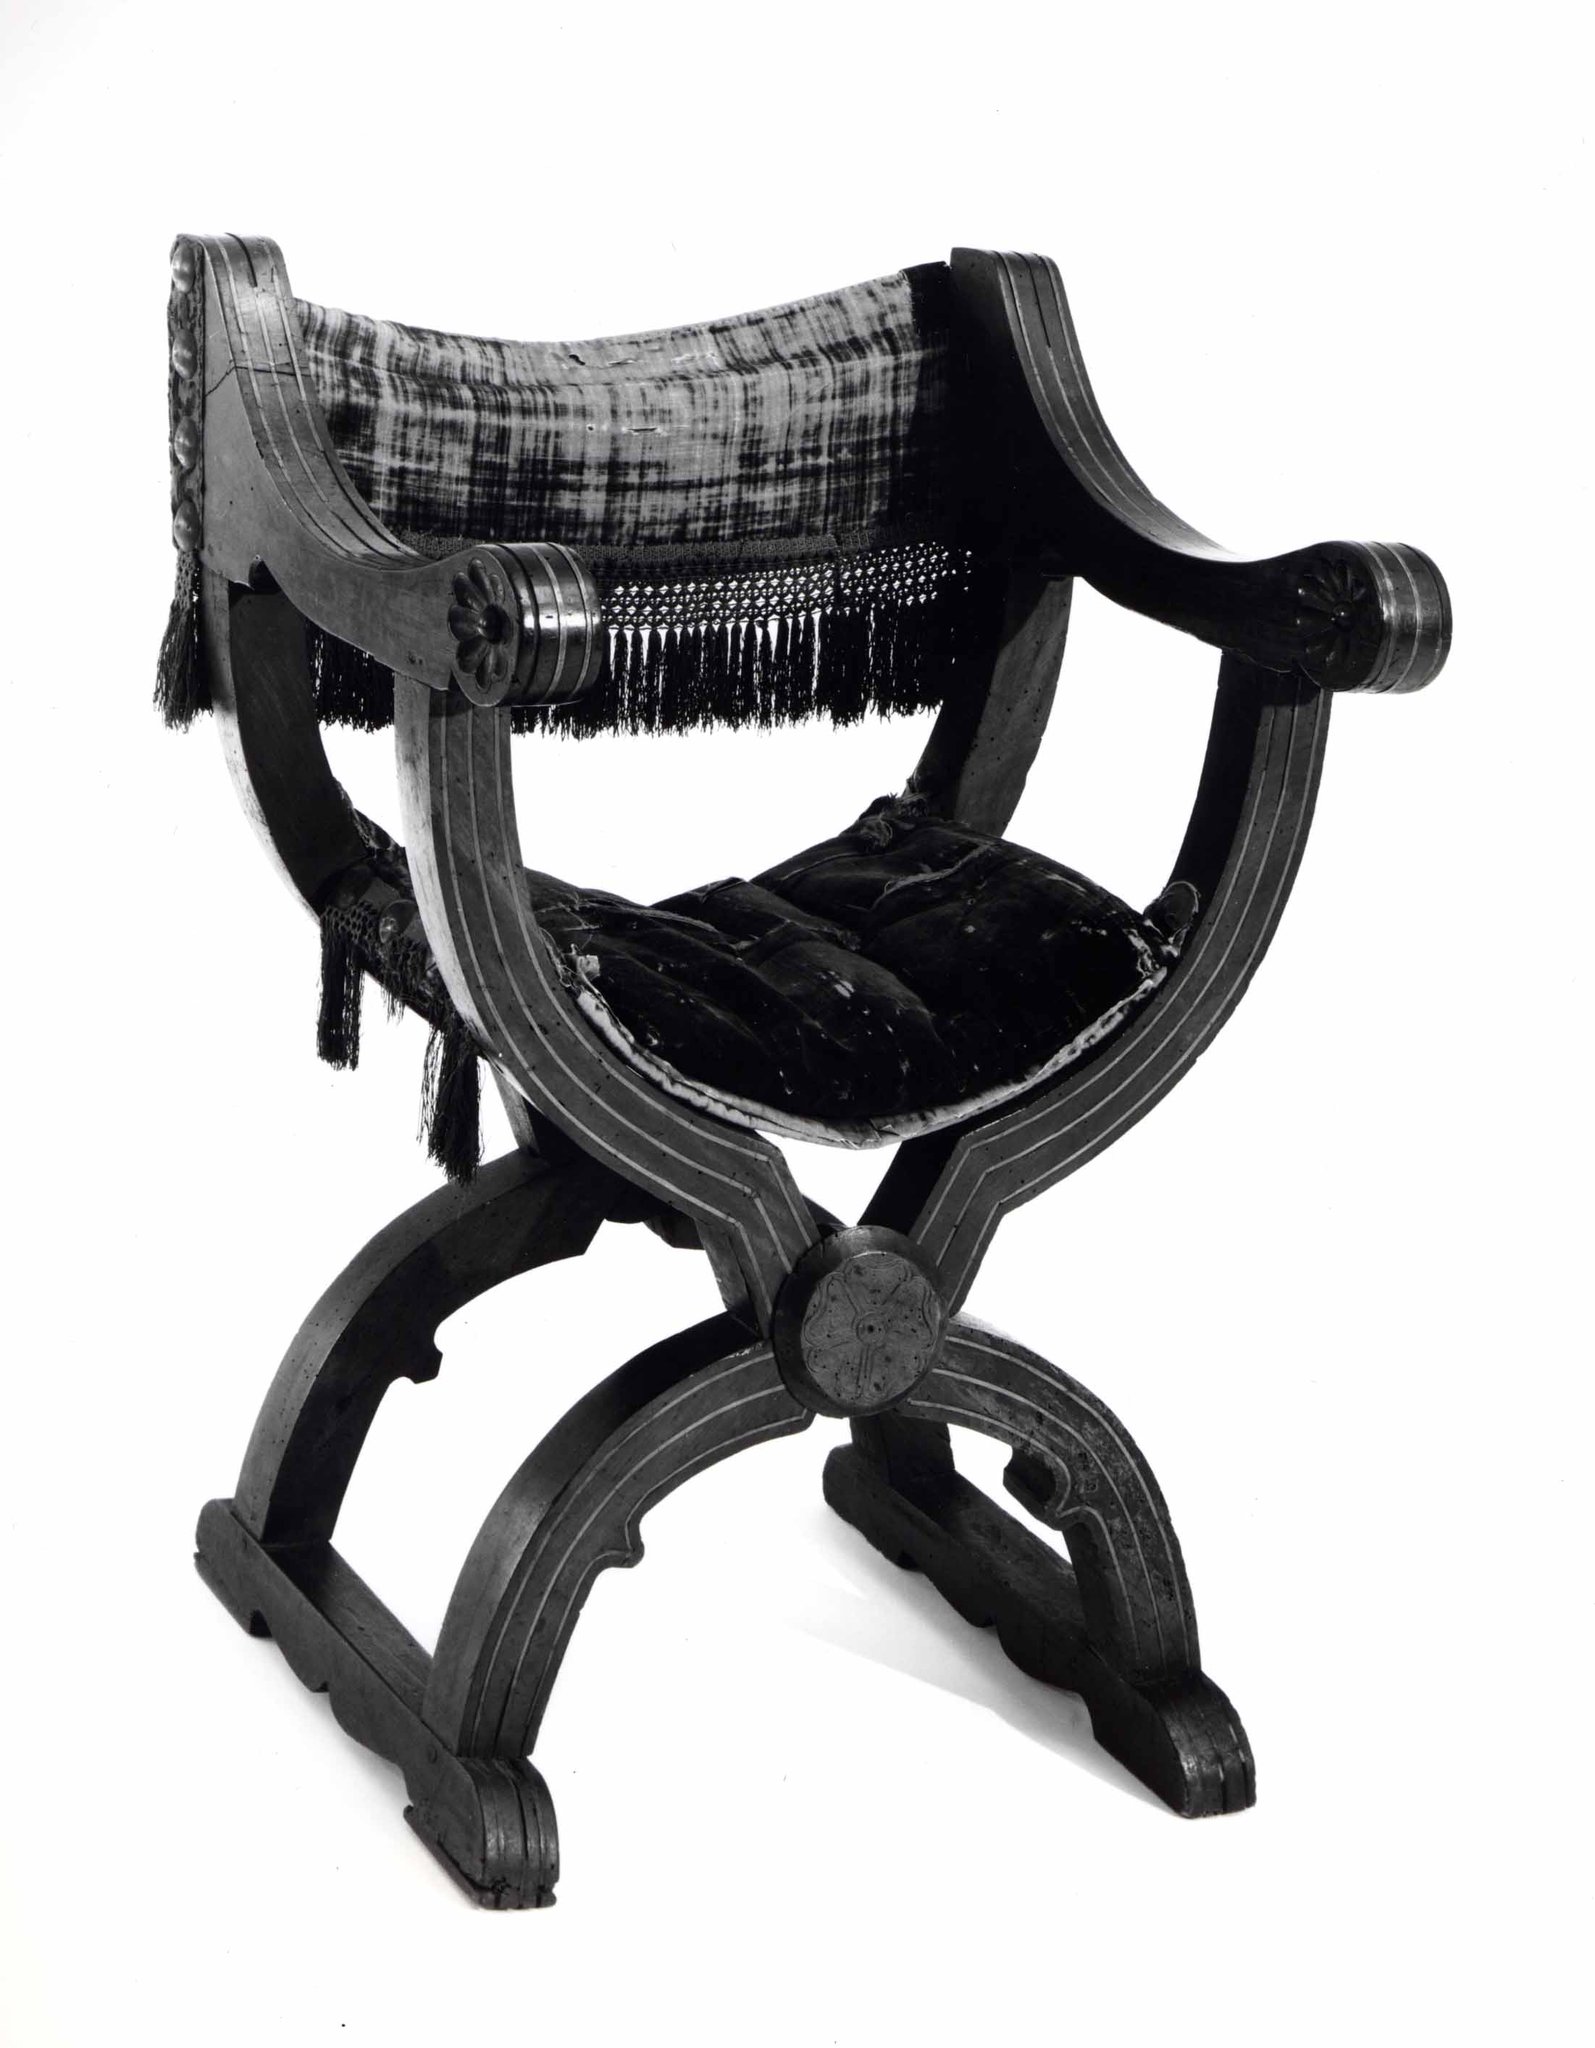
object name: armchair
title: Hip-joint armchair (Dantesca type)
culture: italian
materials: metal, silk, velvet, wood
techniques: carving, embroidery